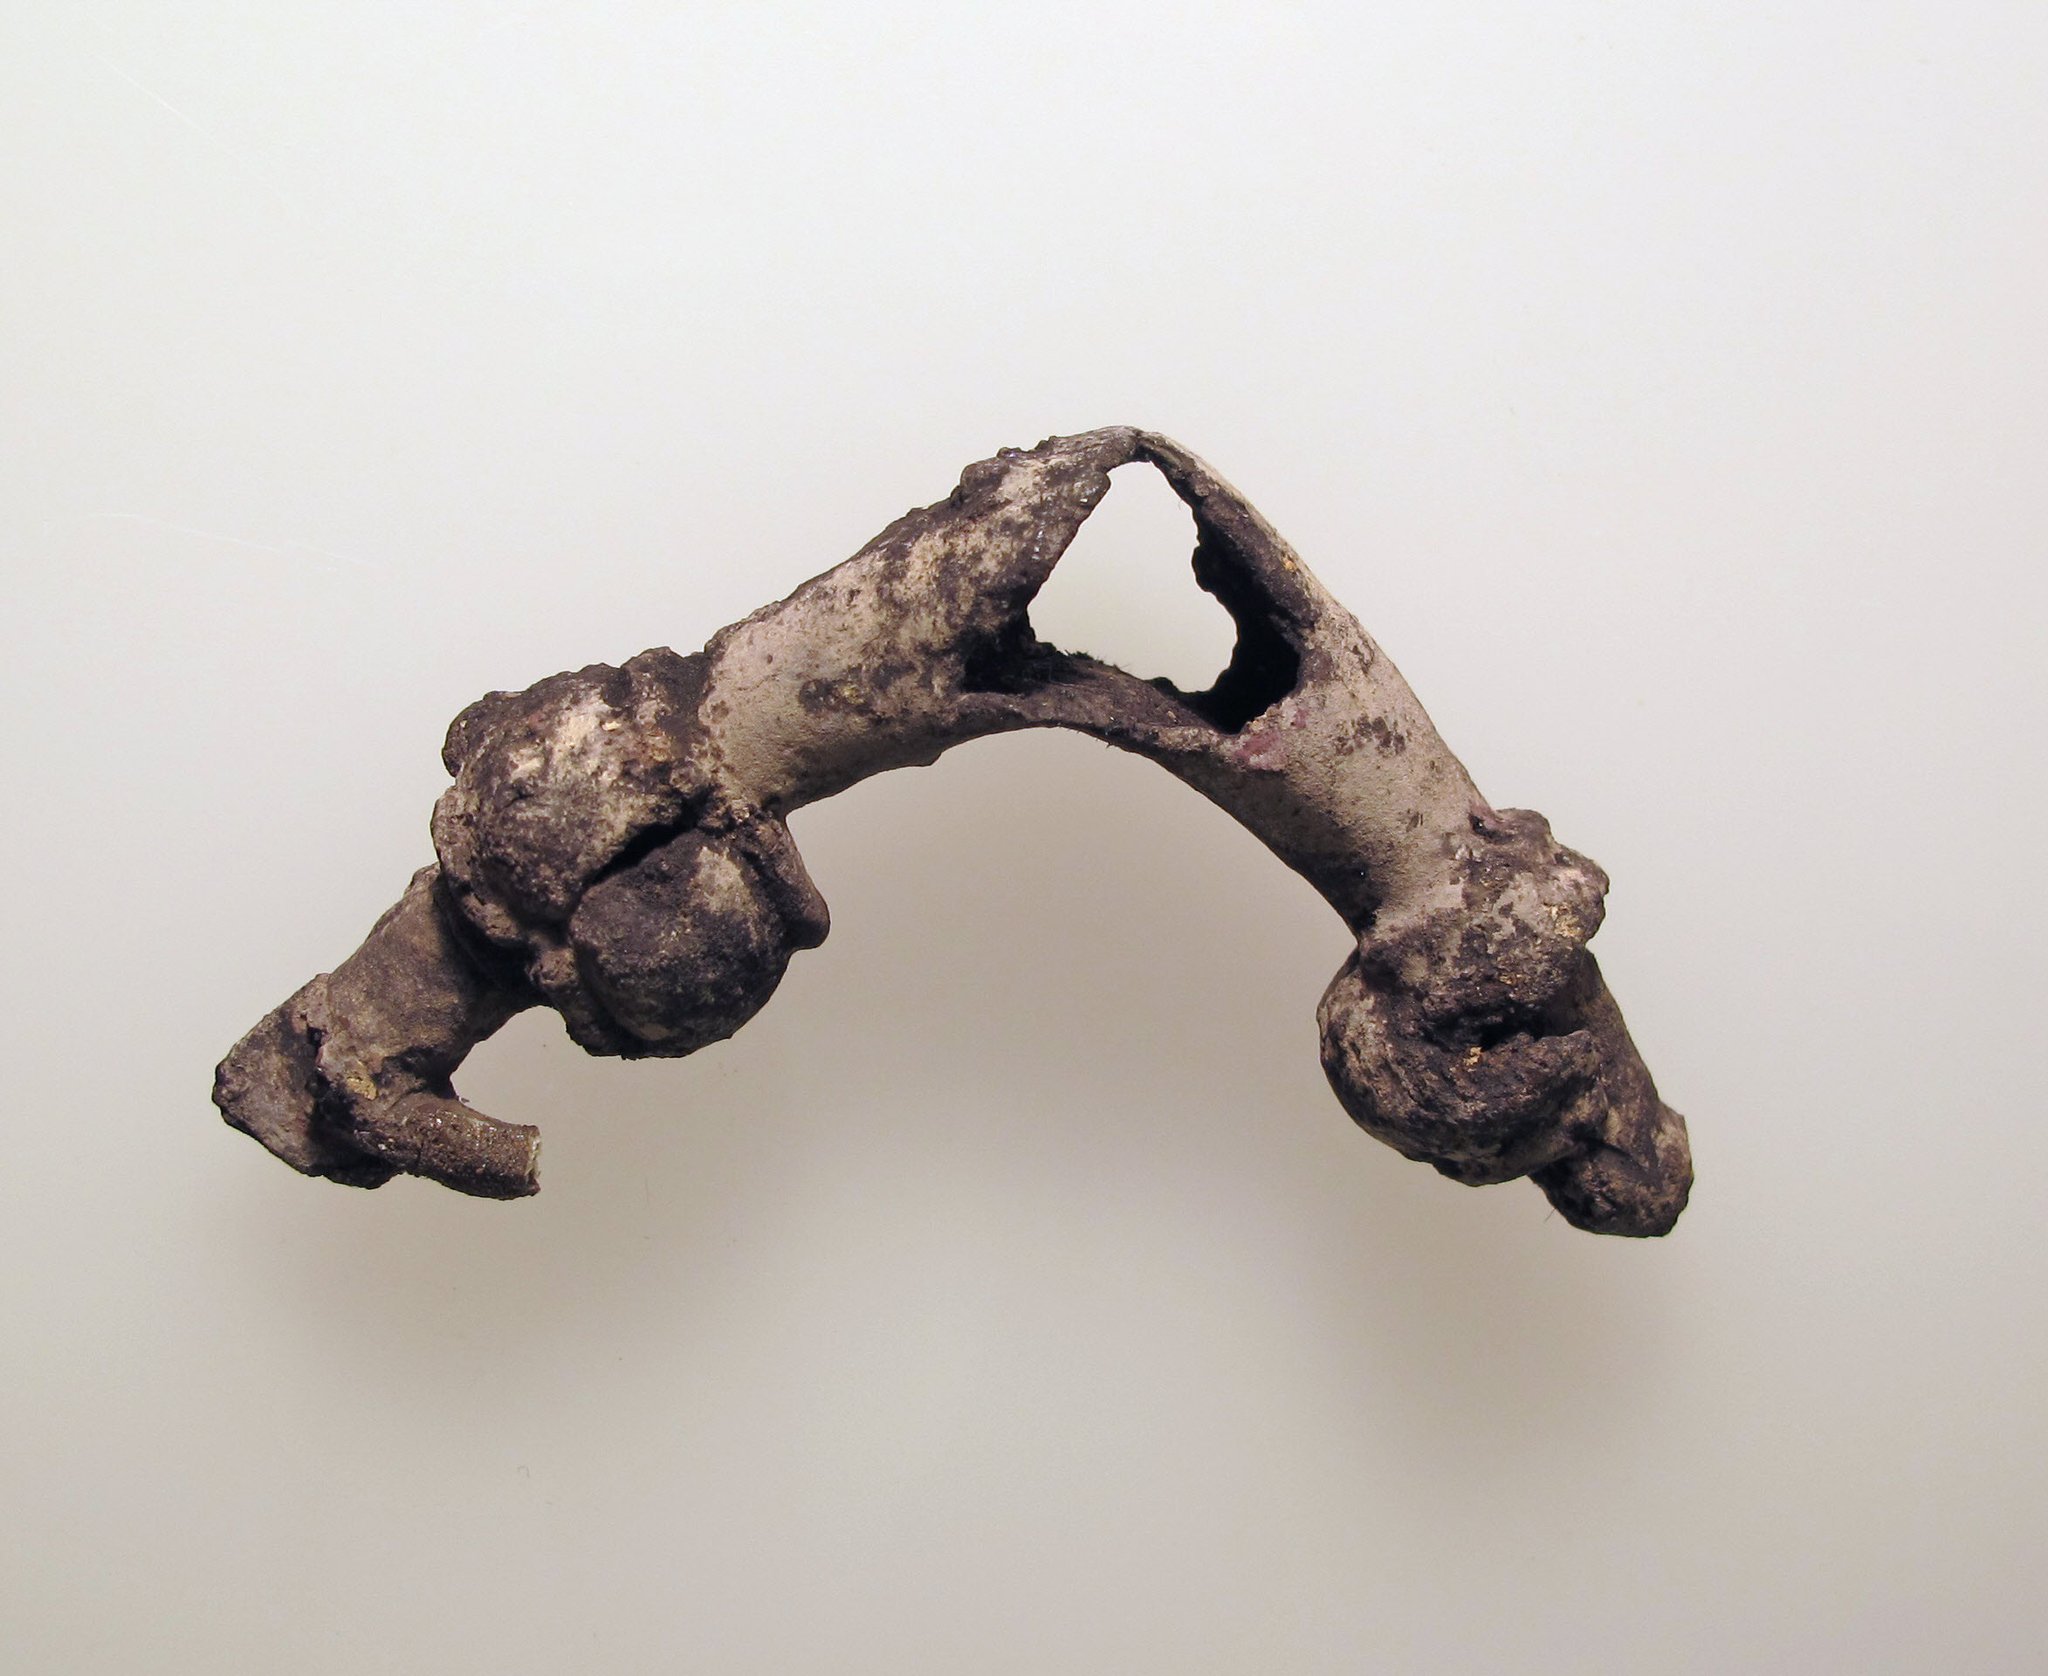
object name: fibula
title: Silver fibula (safety pin)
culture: cypriot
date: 3900 BCE-100 CE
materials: silver